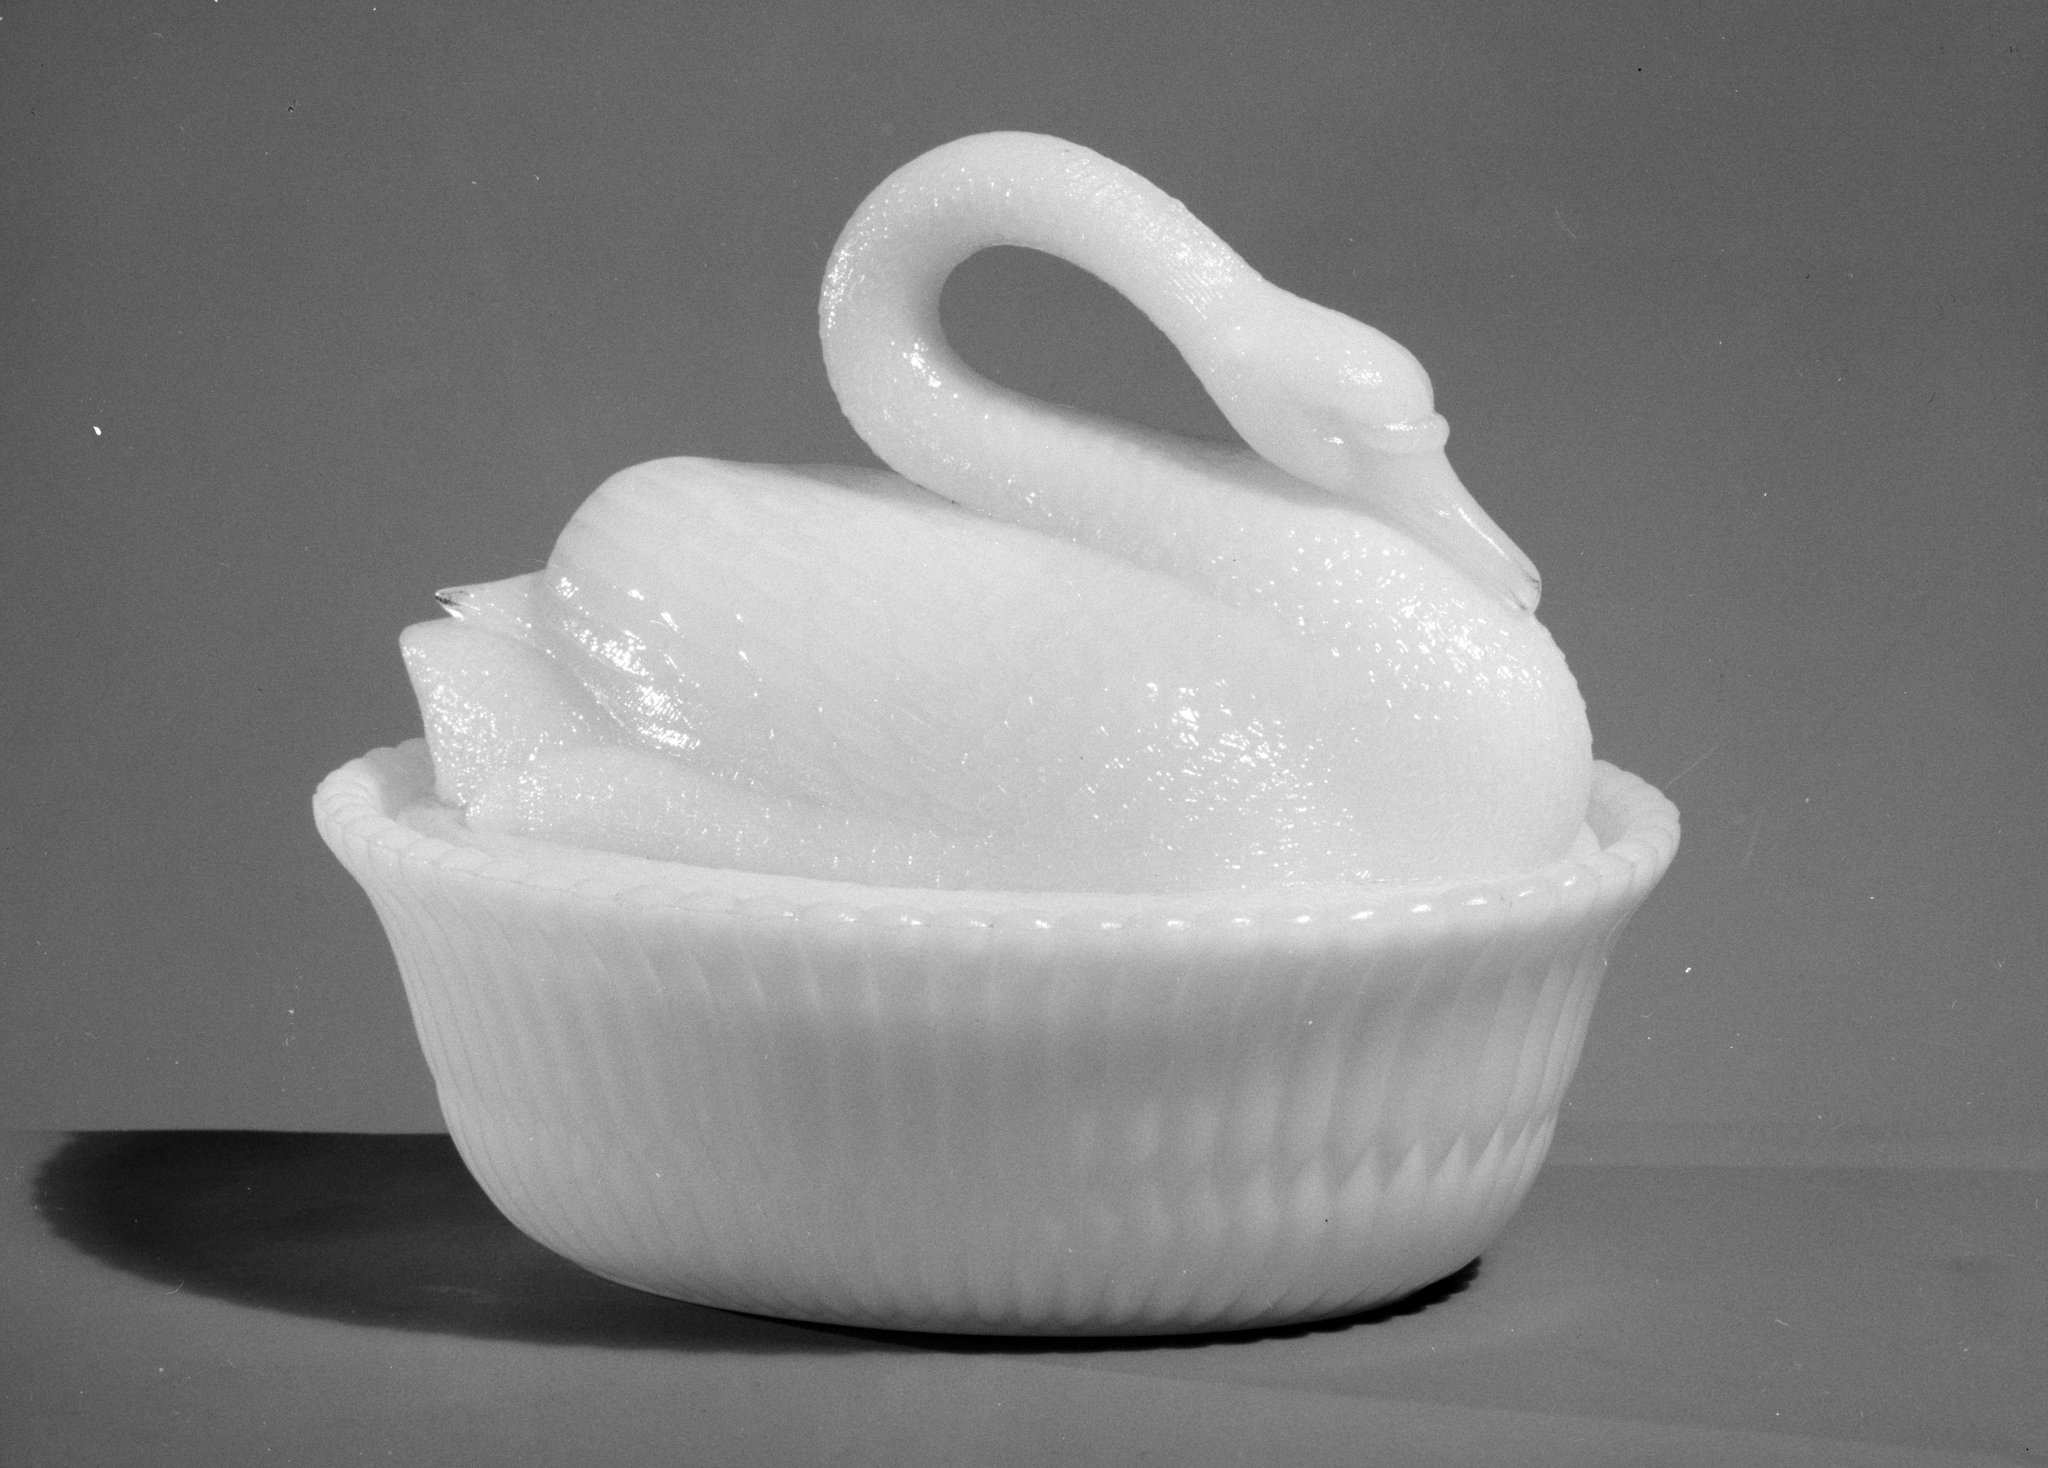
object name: dish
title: Figure Dish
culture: american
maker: mckee and brothers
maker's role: maker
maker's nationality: american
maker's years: 1856-1889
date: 1880-1890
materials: glass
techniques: pressed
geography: united states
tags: swans